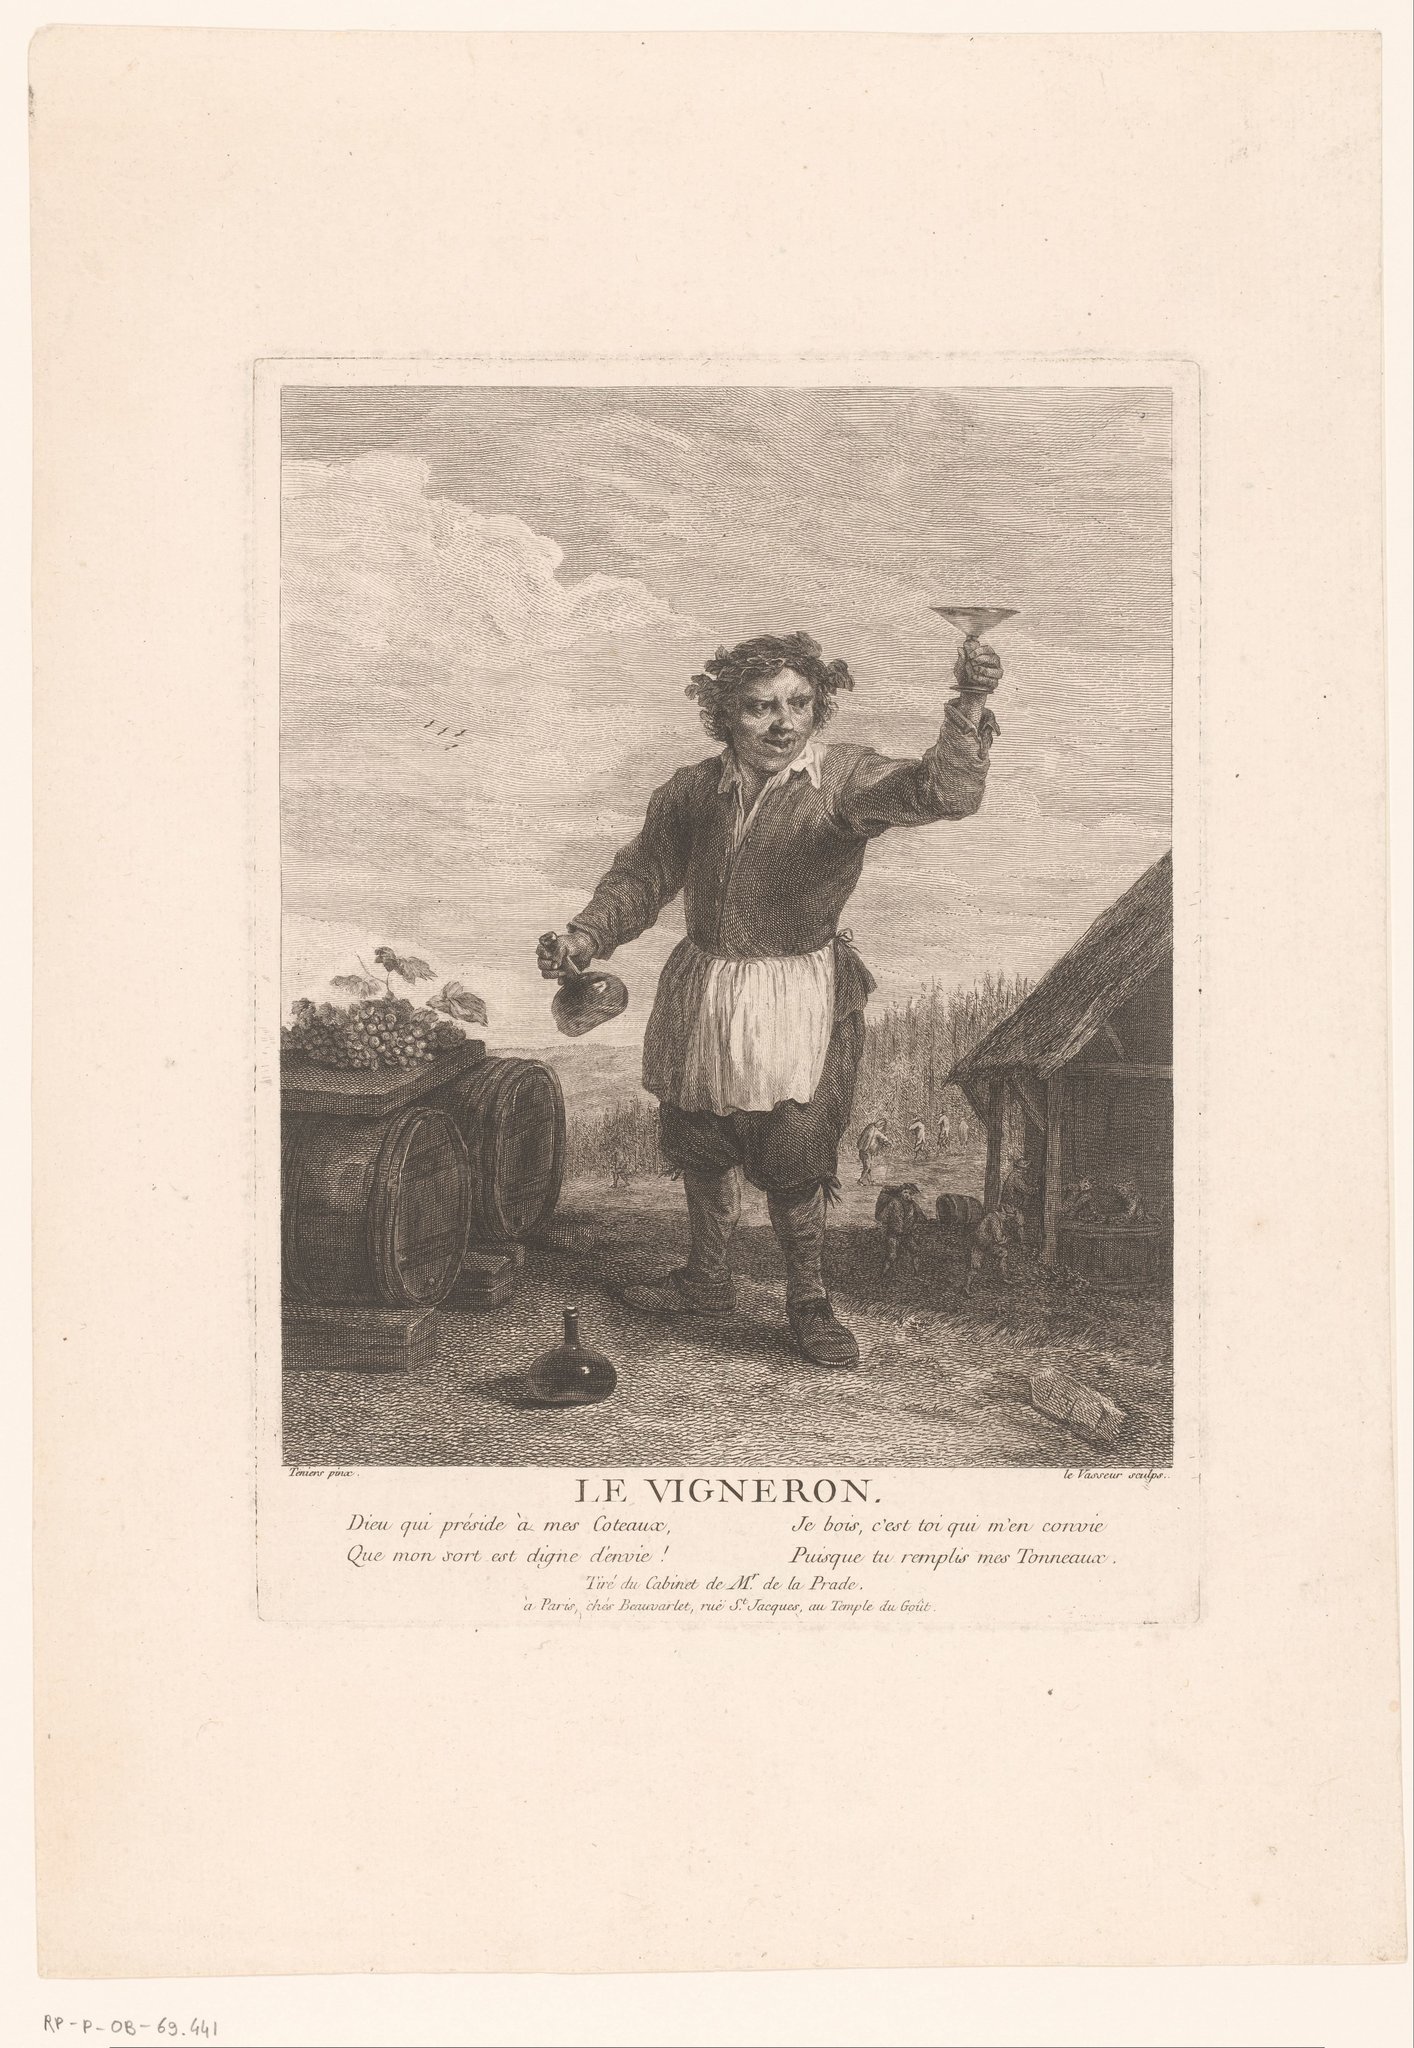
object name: print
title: Le Vigneron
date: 1744-1797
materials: paper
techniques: engraving, etching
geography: paris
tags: vineyard, wine production, farmers, glass of wine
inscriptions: collector's mark: Lugt 2228